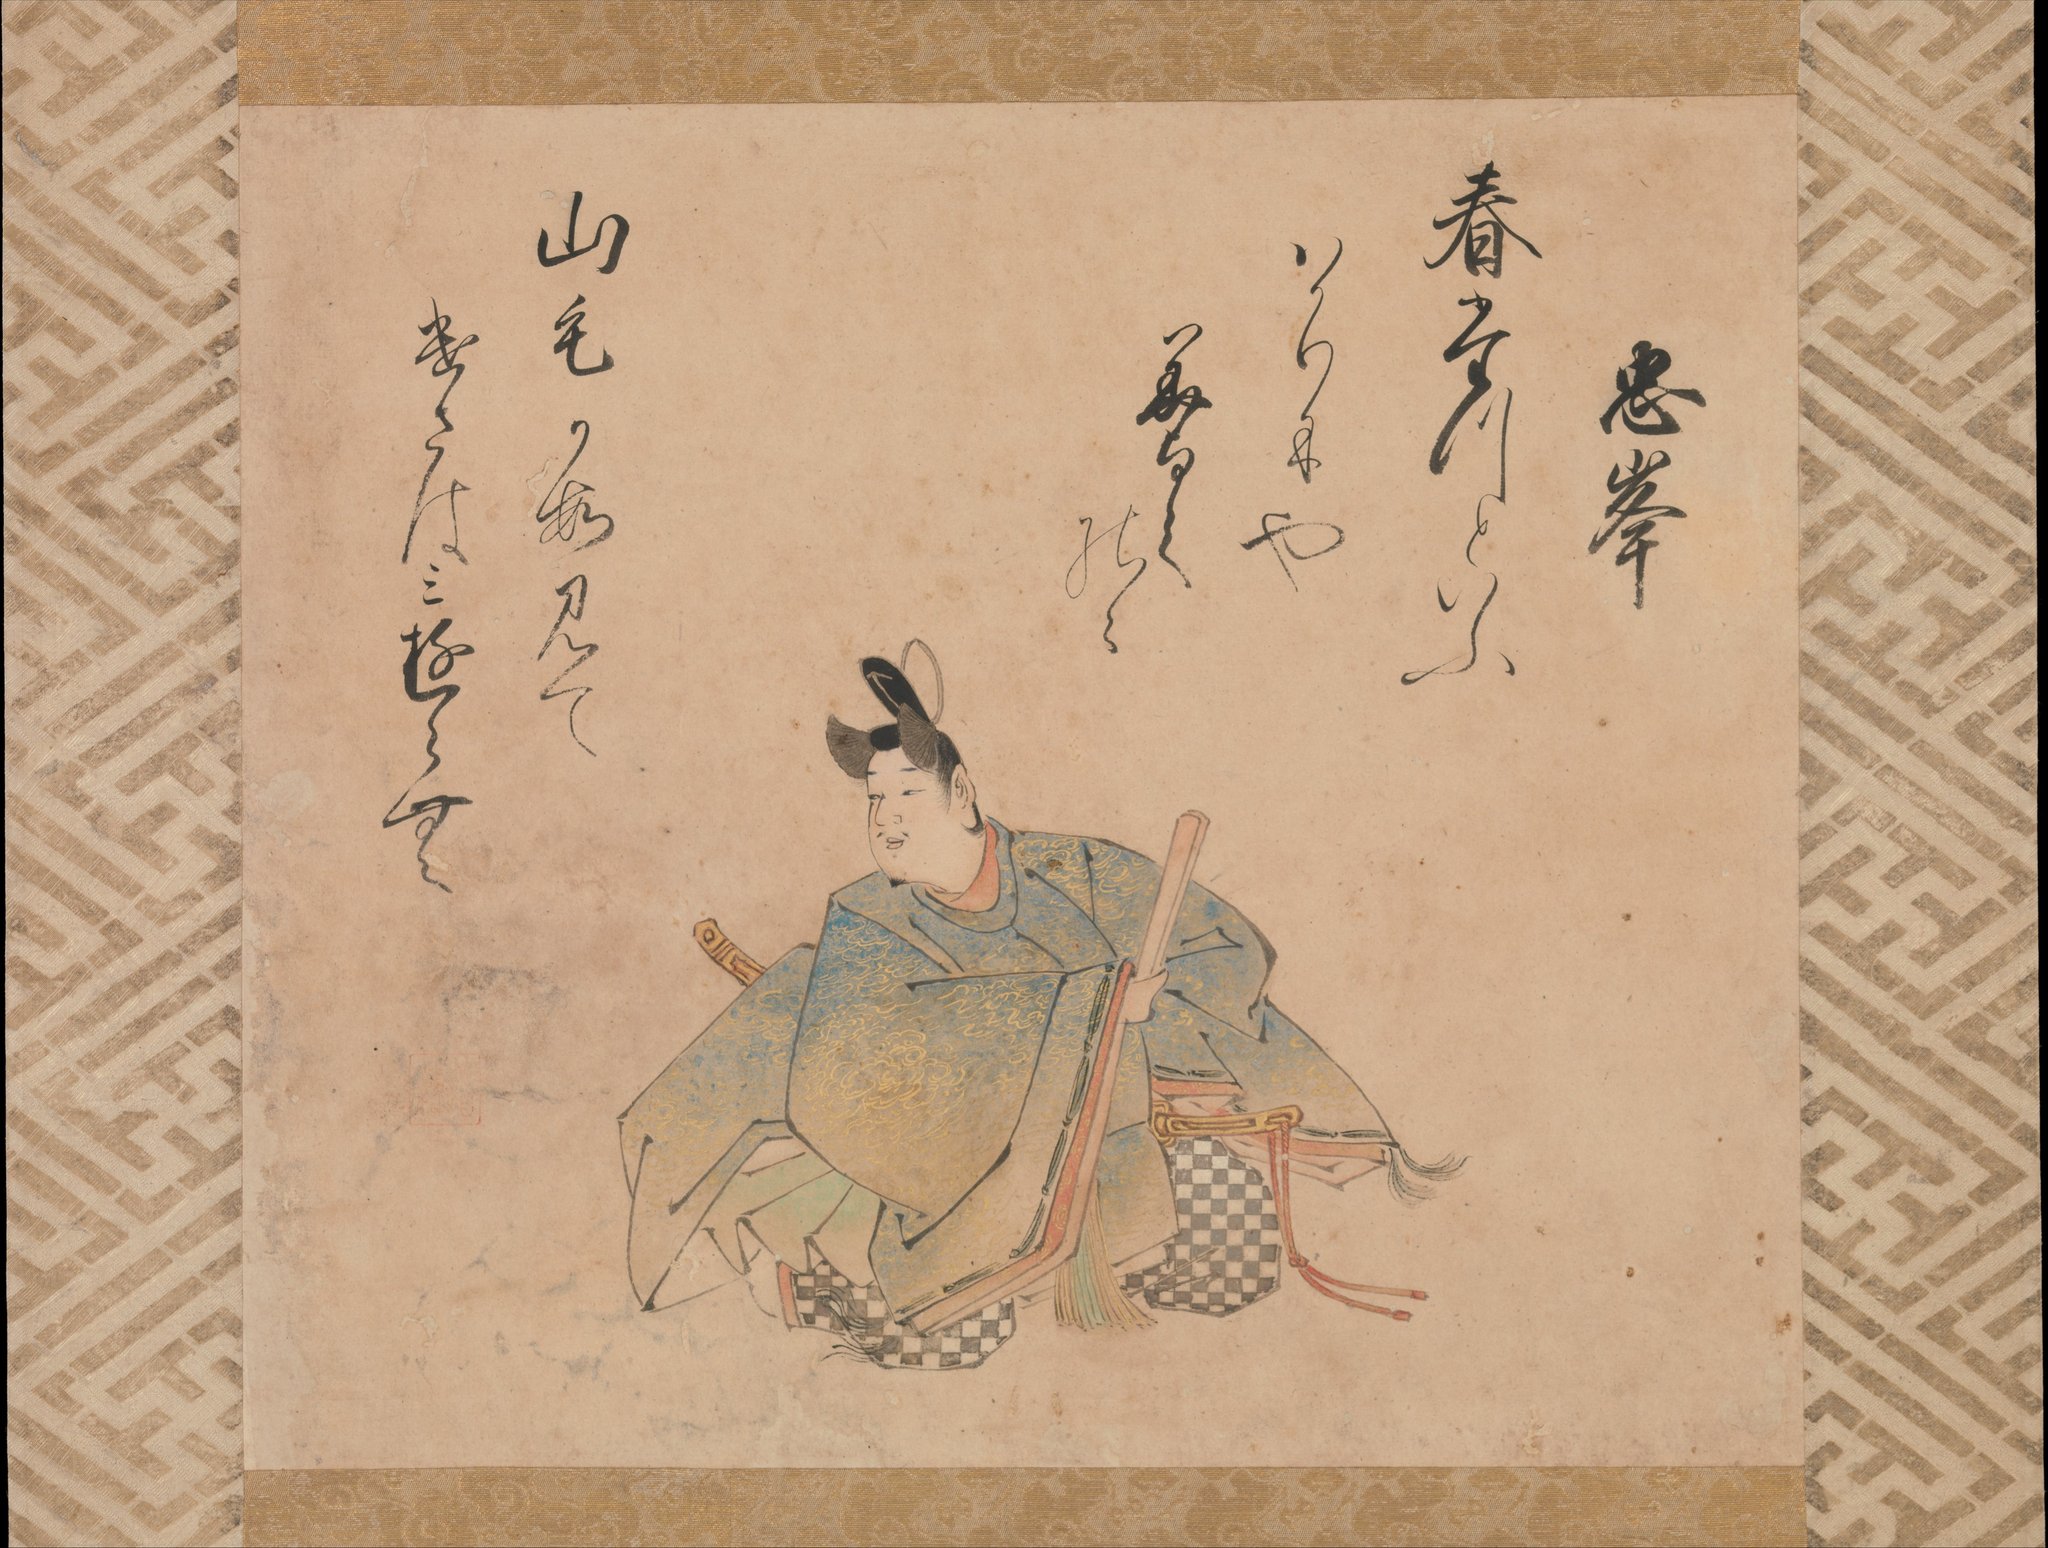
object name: hanging scroll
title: The Poet Mibu no Tadamine, from a set of album leaves illustrating The Thirty-six Poetic Immortals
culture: japanese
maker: iwasa matabei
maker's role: artist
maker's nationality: japanese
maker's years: 1578-1650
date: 1601-1633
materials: gold, ink, paper, silver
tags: men,poets